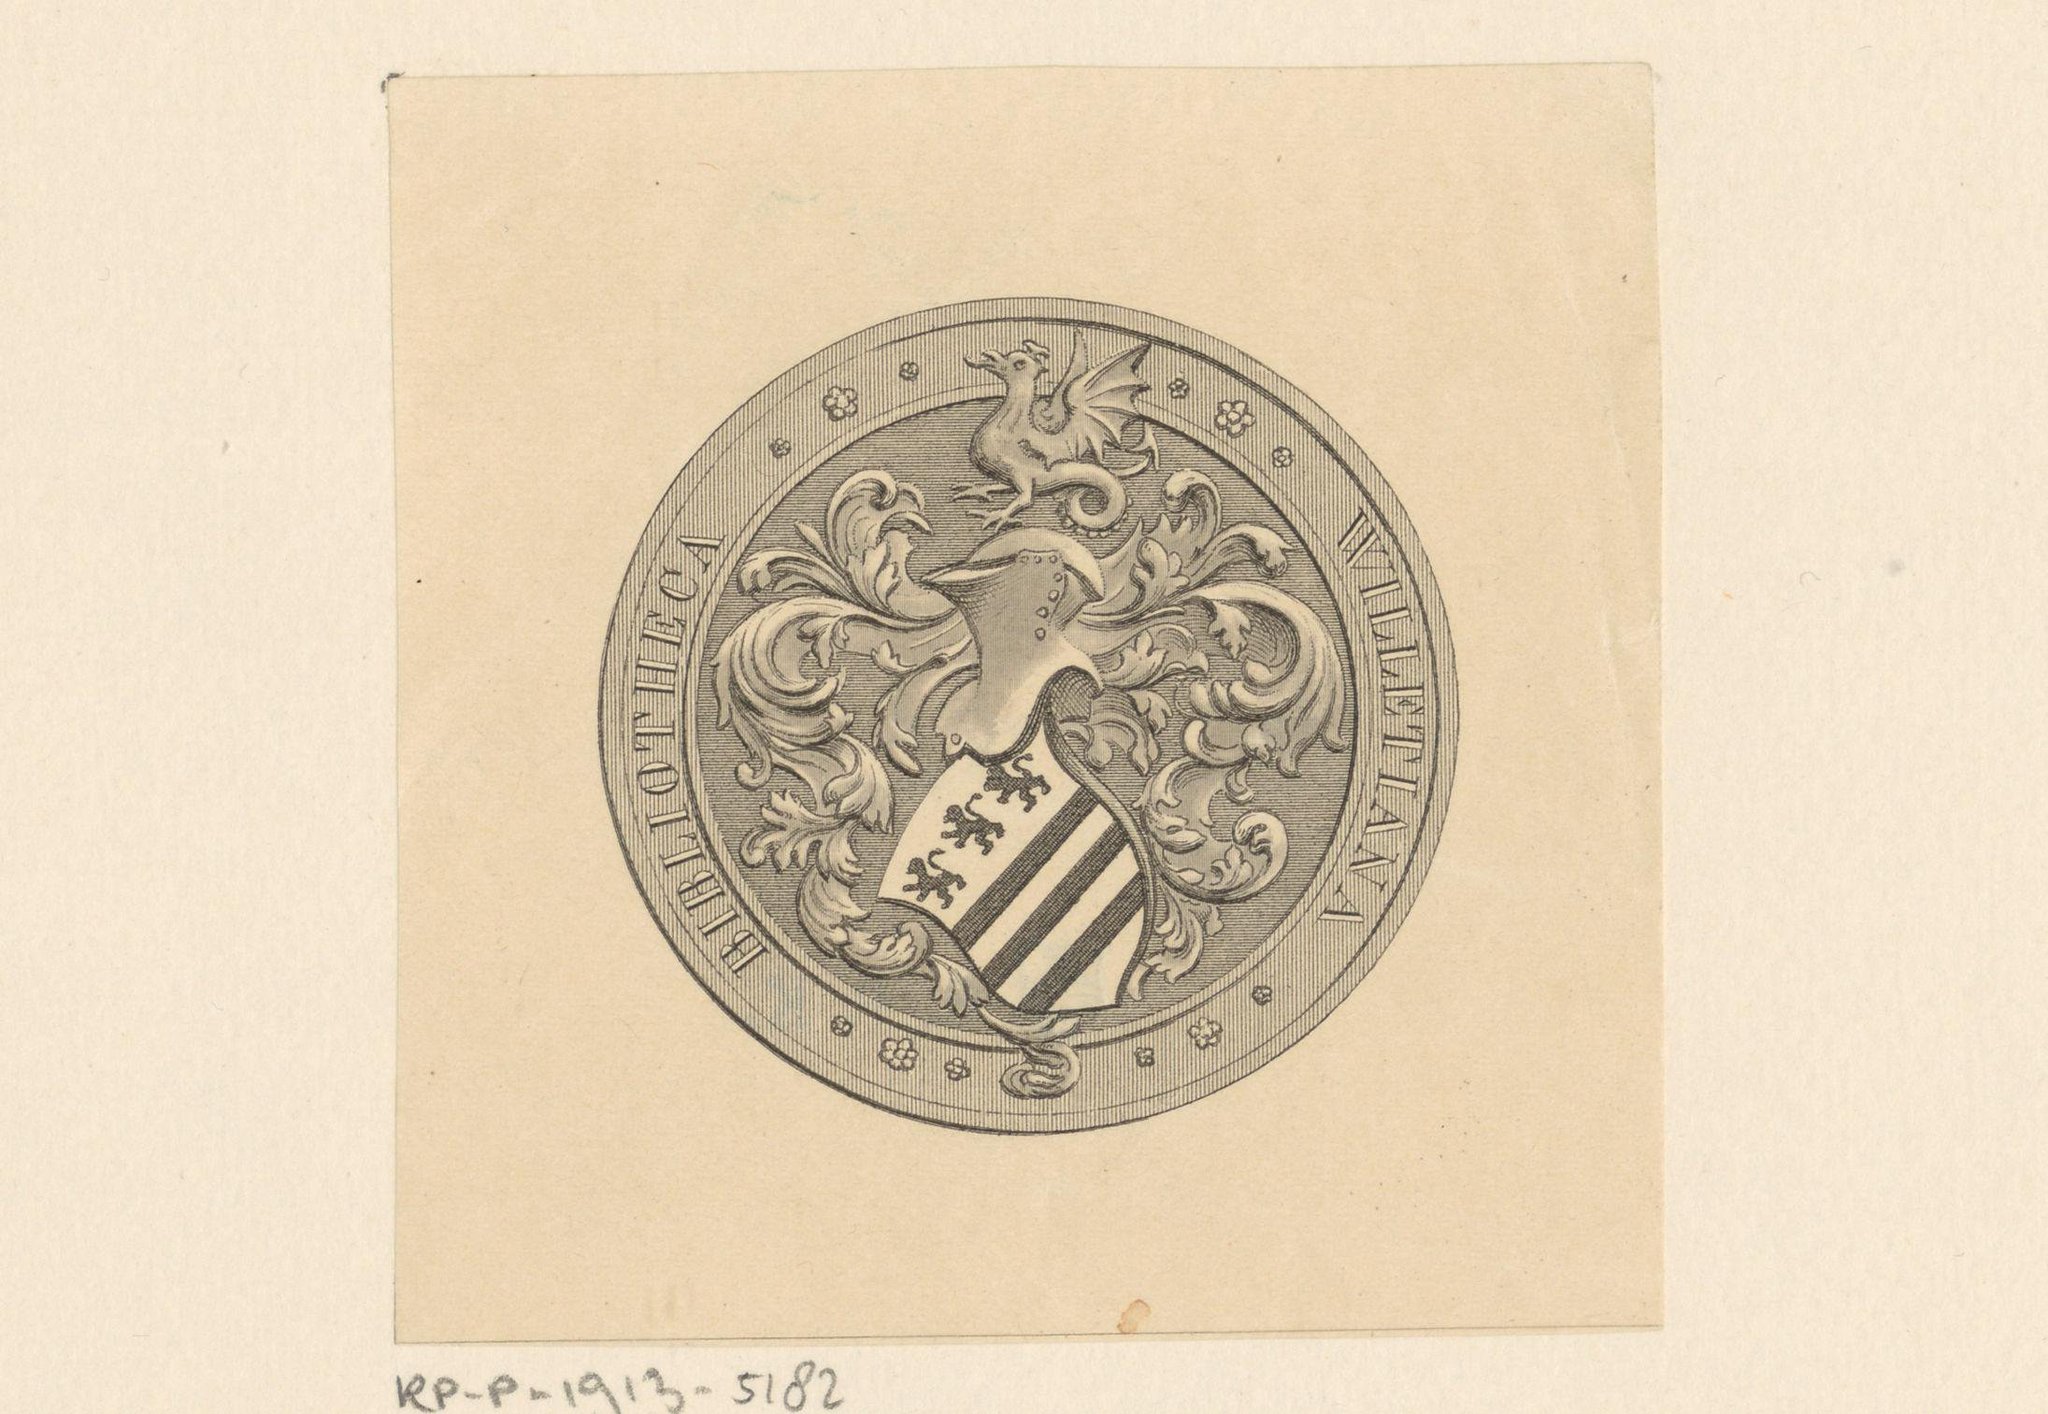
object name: bookplate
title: Ex libris van Abraham Willet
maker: Anonymous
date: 1870-1913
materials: paper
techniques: engraving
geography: netherlands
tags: amsterdam, dragon, armorial bearing, heraldry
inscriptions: collector's mark: Lugt 2233, collector's mark: Lugt 2760